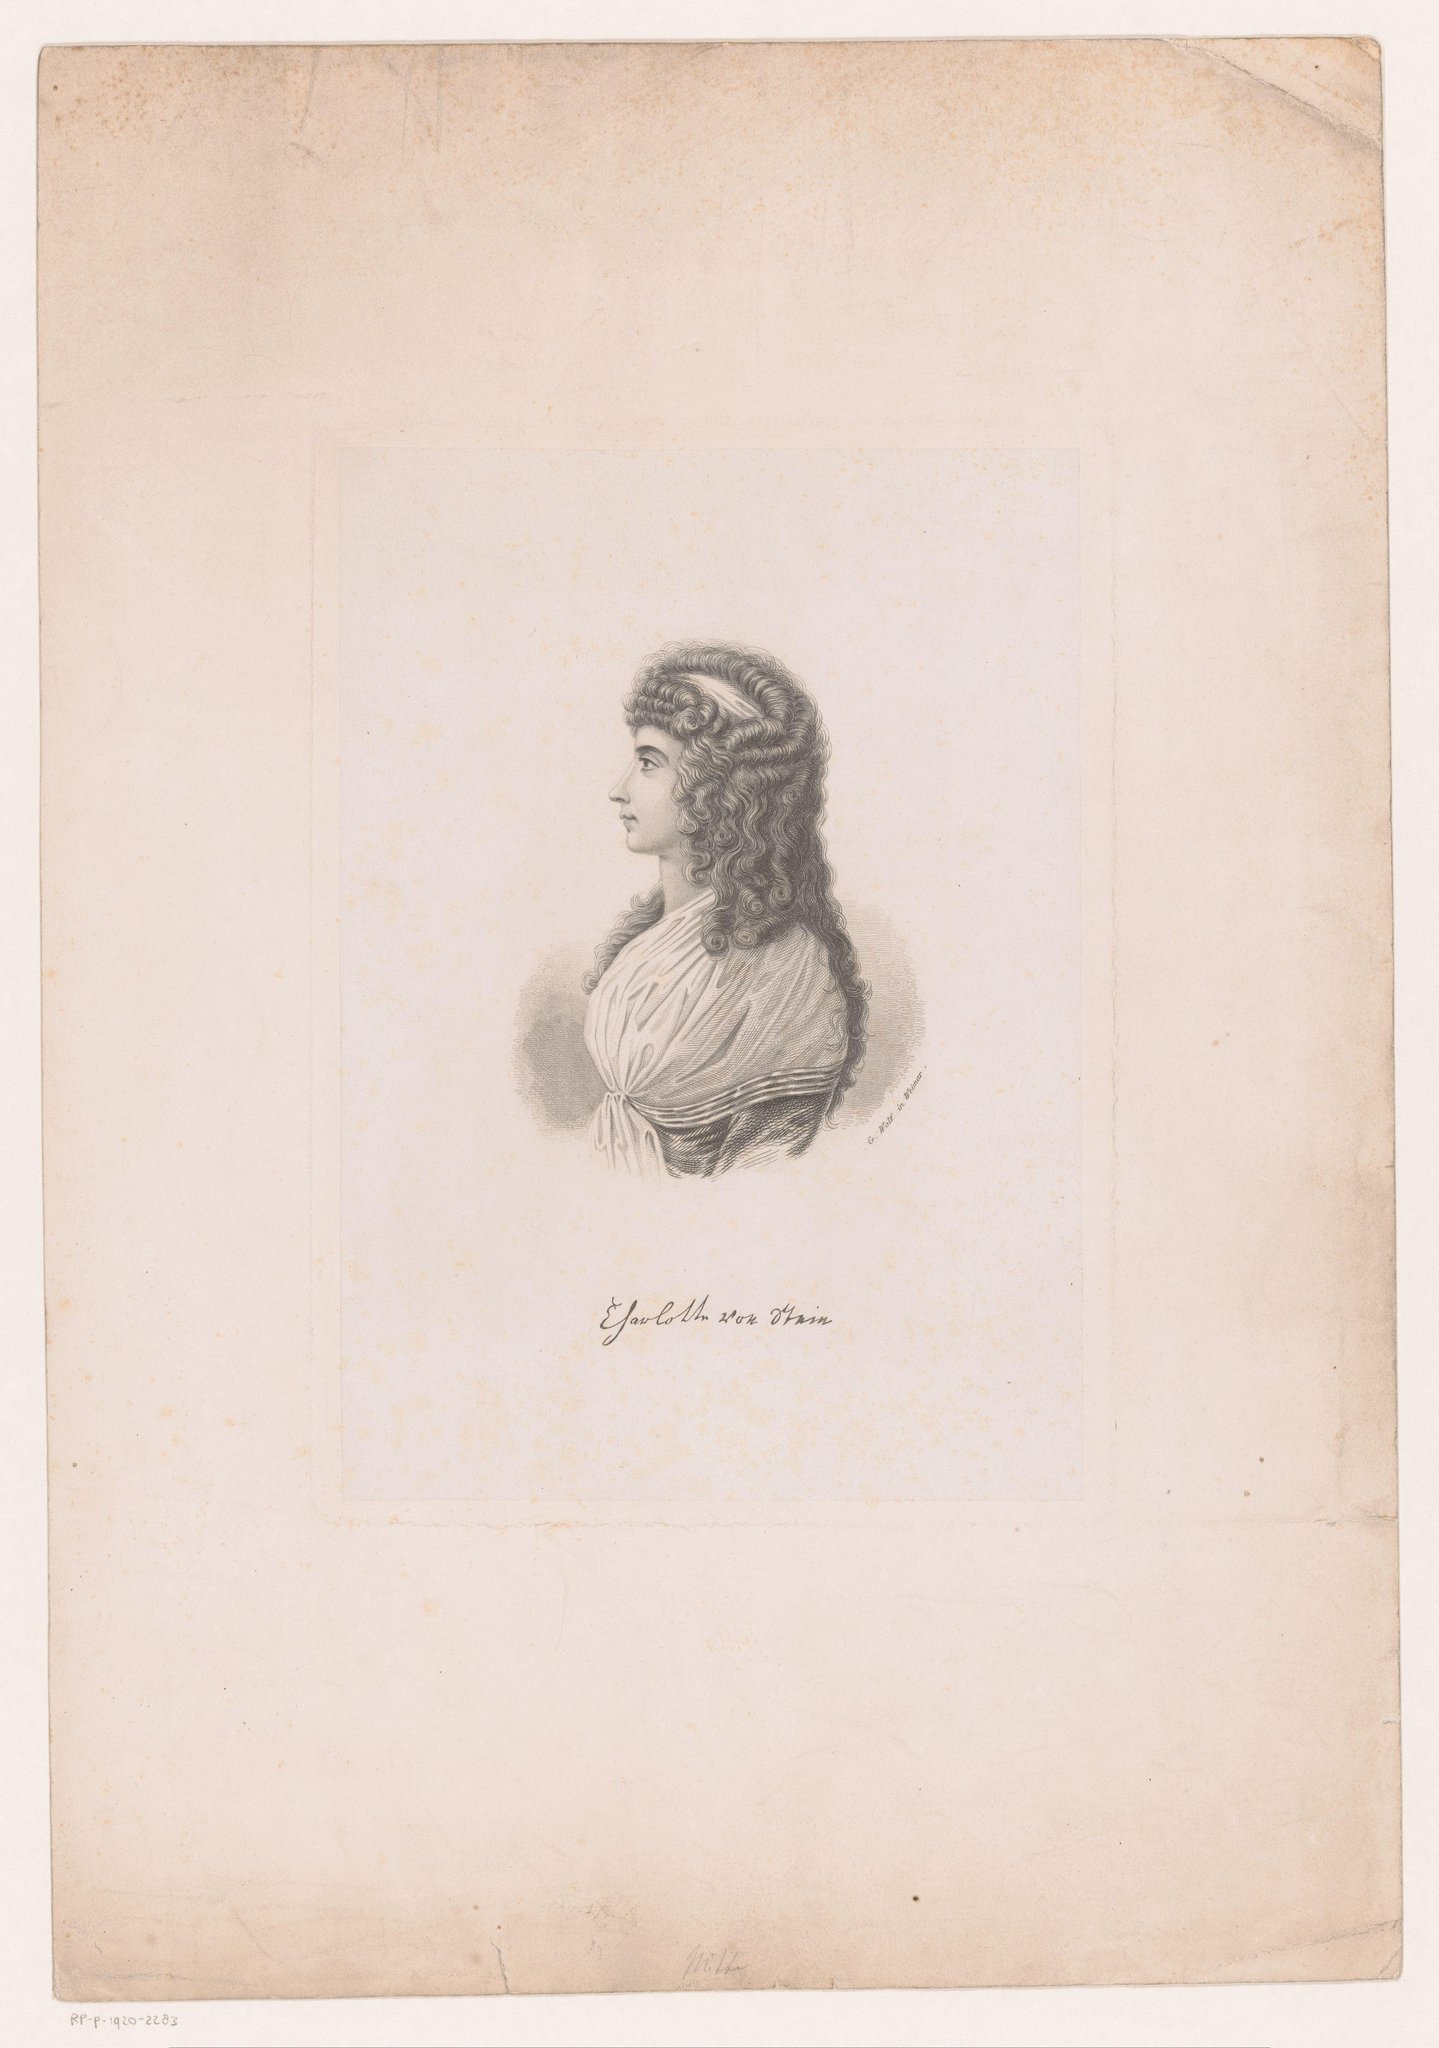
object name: print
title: Portret van Charlotte von Stein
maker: georg wolf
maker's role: print maker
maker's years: 1820-1857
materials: paper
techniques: engraving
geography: weimar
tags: historical persons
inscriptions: collector's mark: Lugt 2228